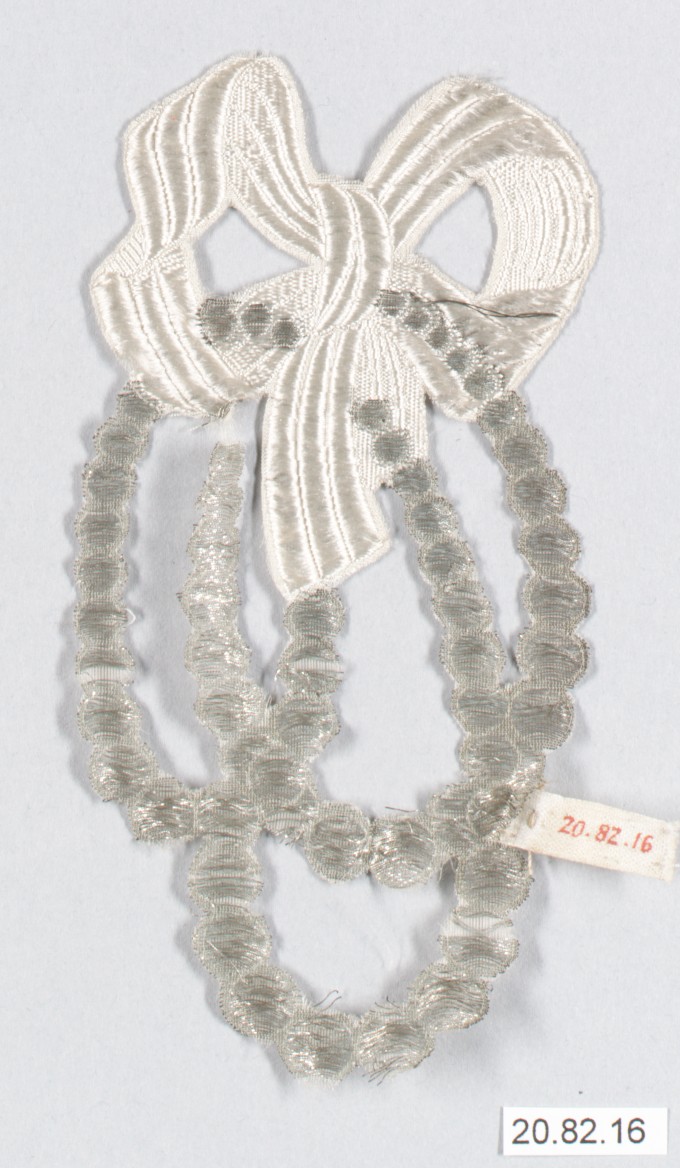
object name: passementerie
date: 1801-1833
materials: metal thread, silk